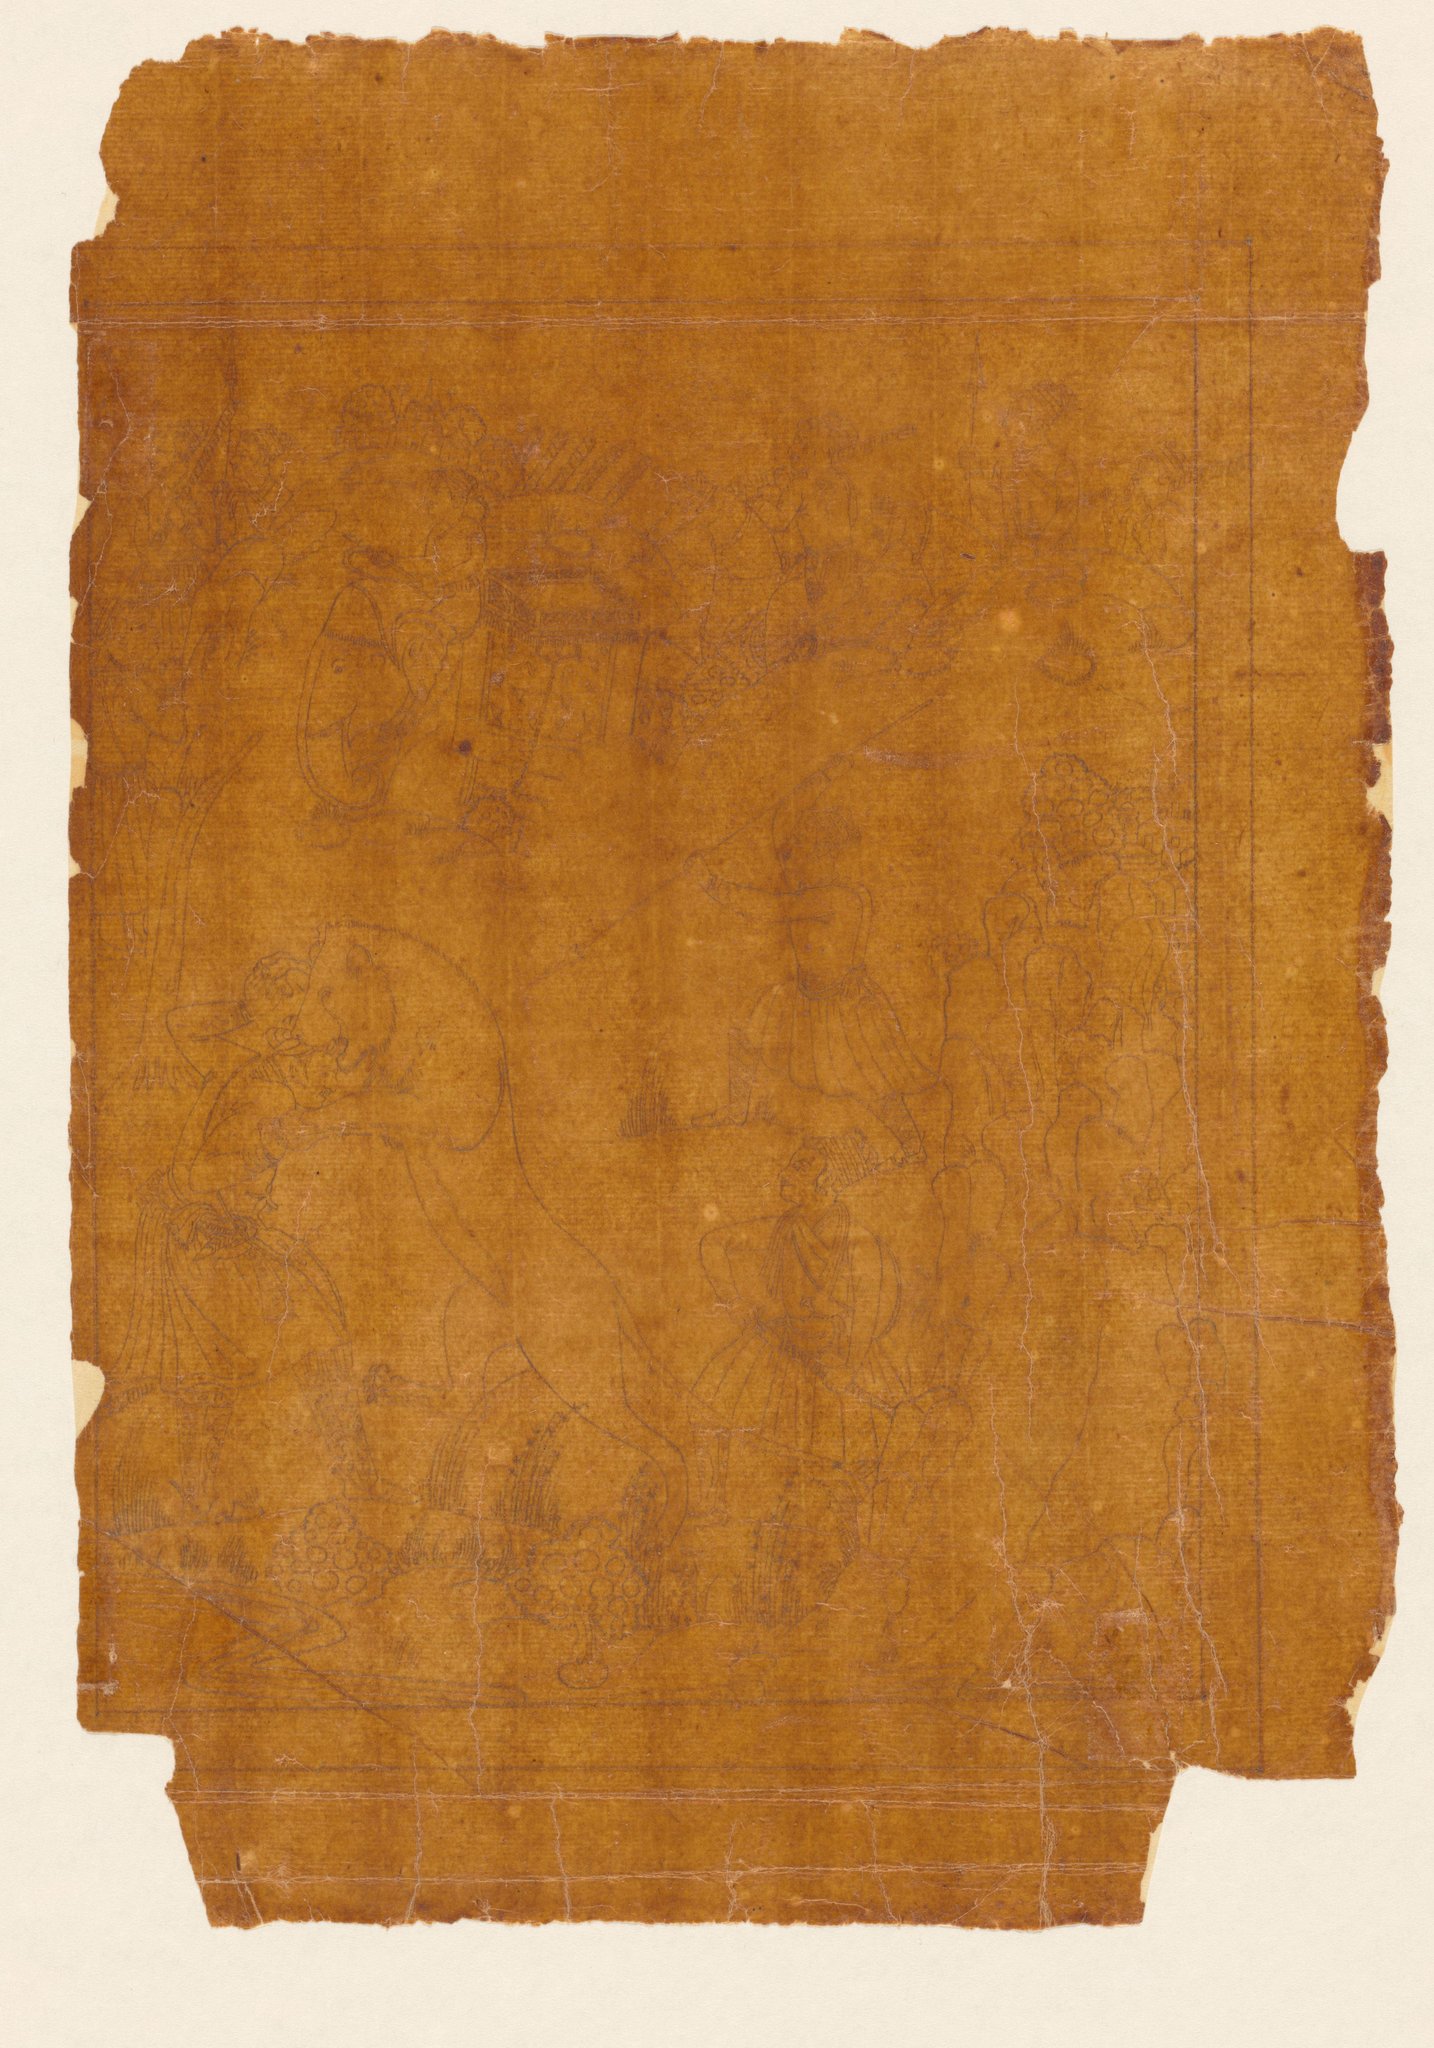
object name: tracing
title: Landschap met Aziatische jagers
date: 1751-1850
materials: chalk, paper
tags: asiatic races and peoples, hunting, chase, trunked animals: elephant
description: Aziatische jagers in een landschap. Op de achtergrond zit een man op een olifant. Daarvoor vecht een man met mogelijk een tijger. De beer wordt in de rug aangevallen door een man met een speer. Een andere man trekt zijn mes. De calque ligt los achterin een album.